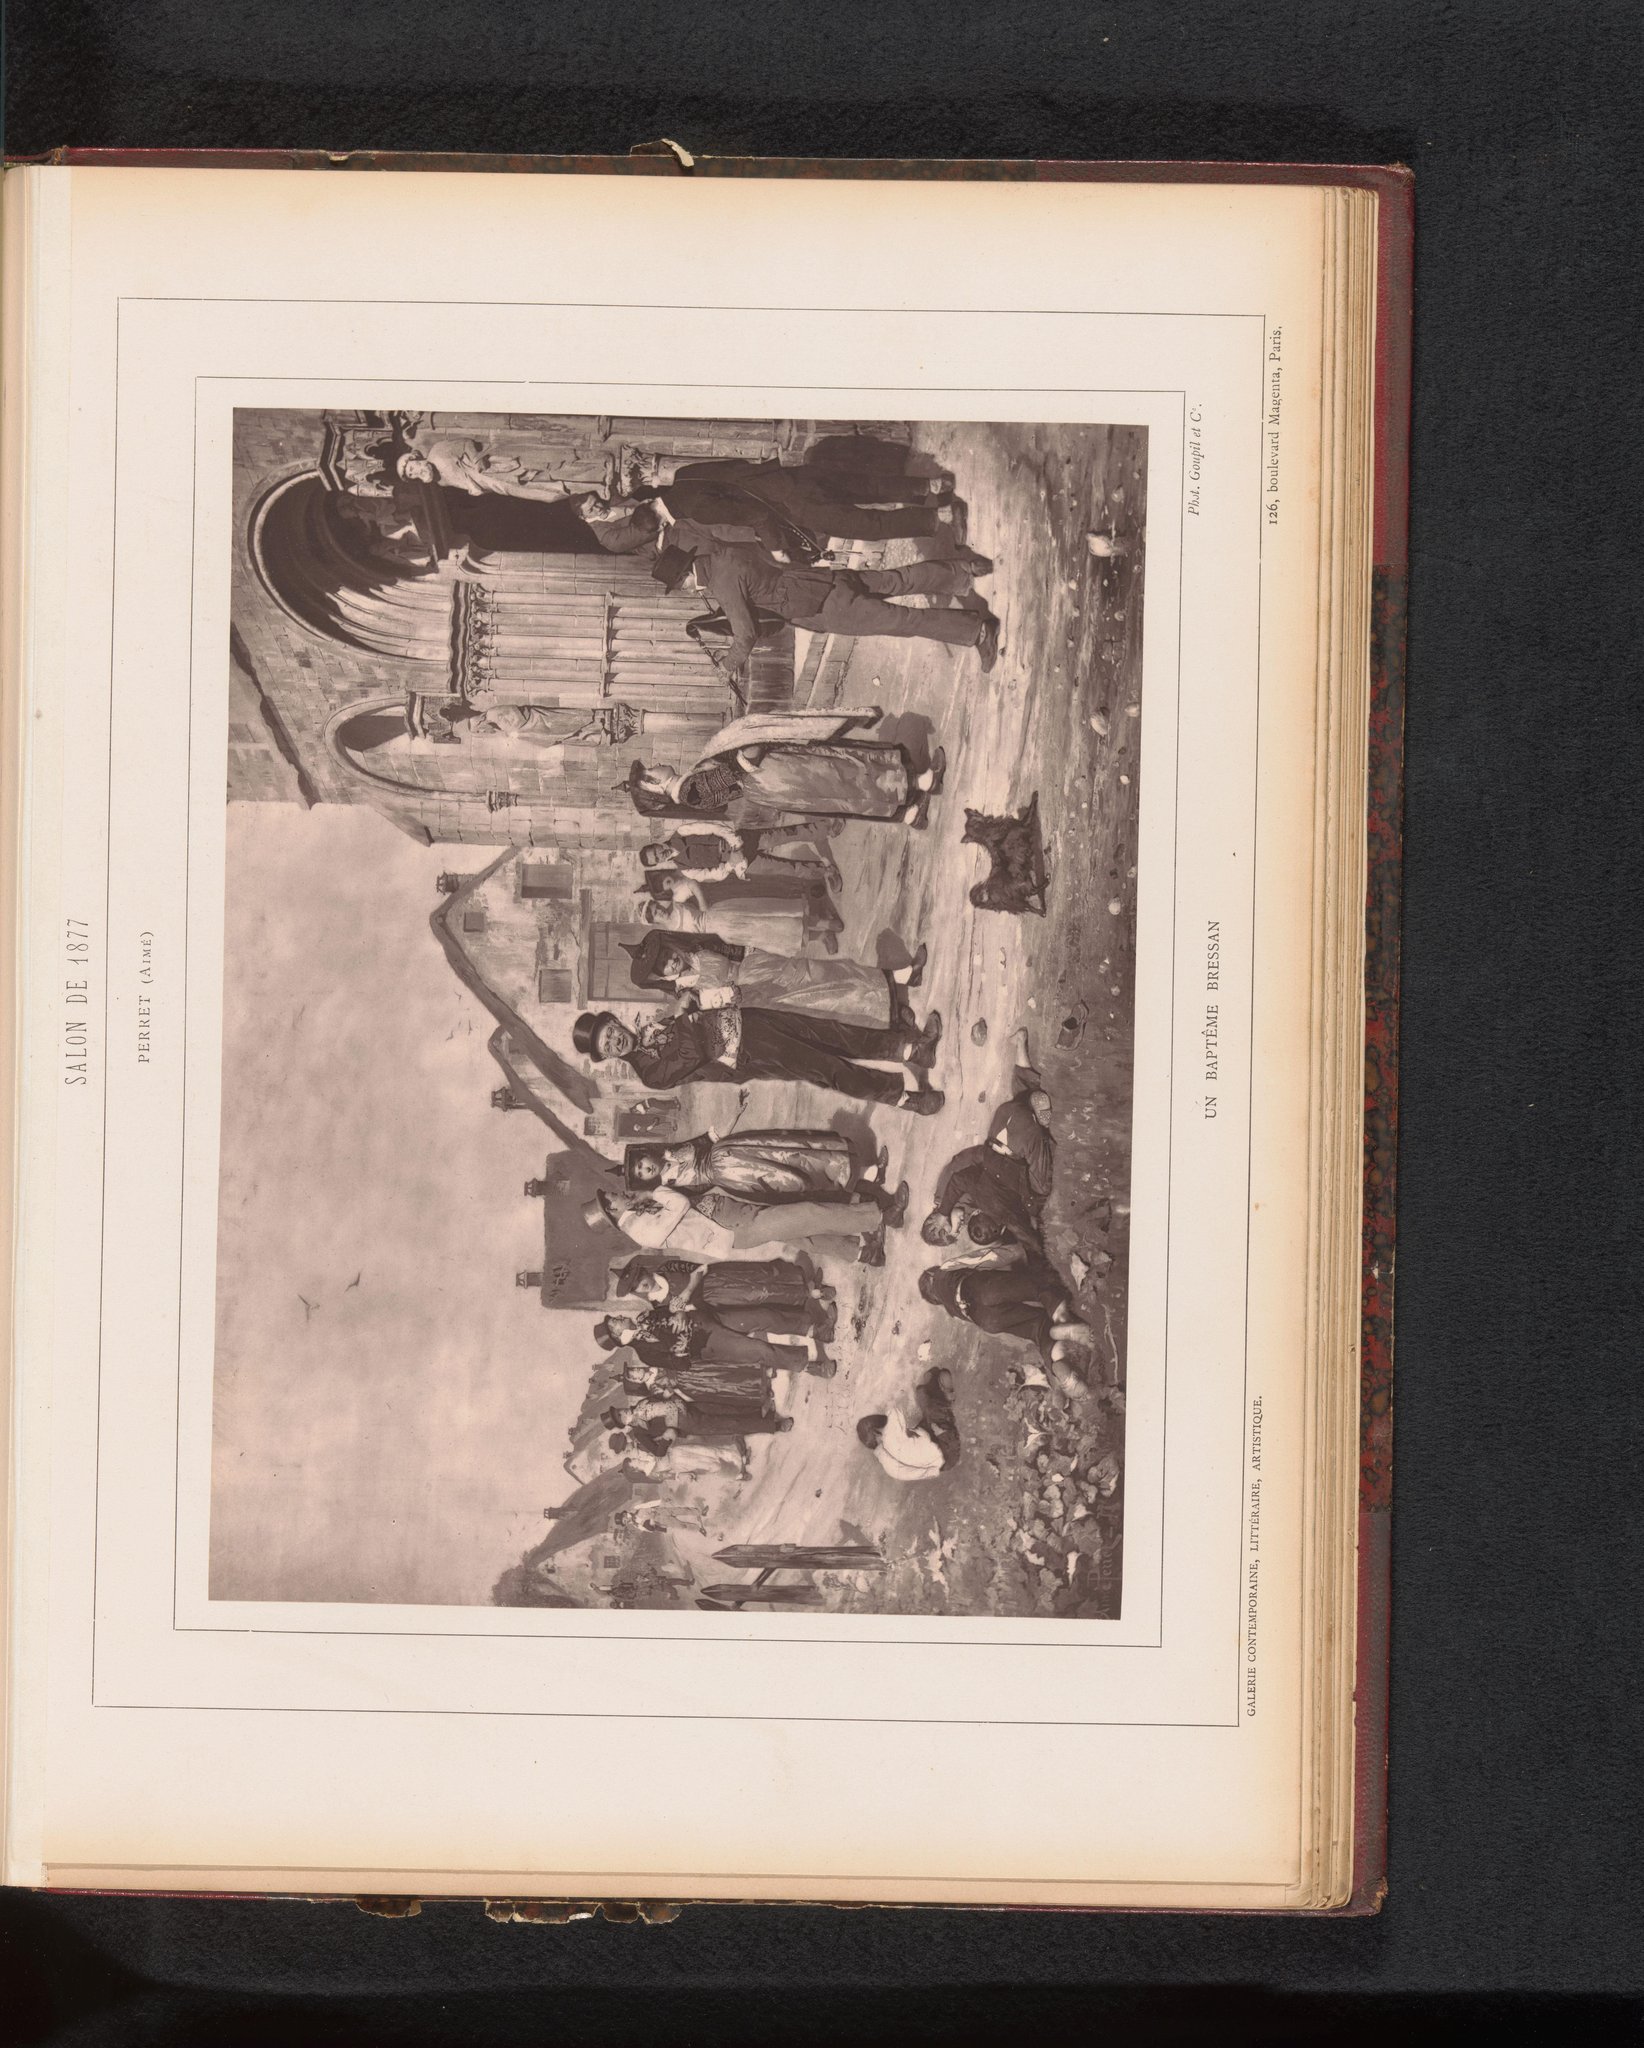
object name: page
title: Un baptême bressan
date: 1872-1877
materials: paper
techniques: woodburytype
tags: entering the church, painting, drawing and the graphic arts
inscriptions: inscription: ‘Galerie Contemporaine, Littéraire, Artistique/ 126, boulevard de Magenta, Paris’